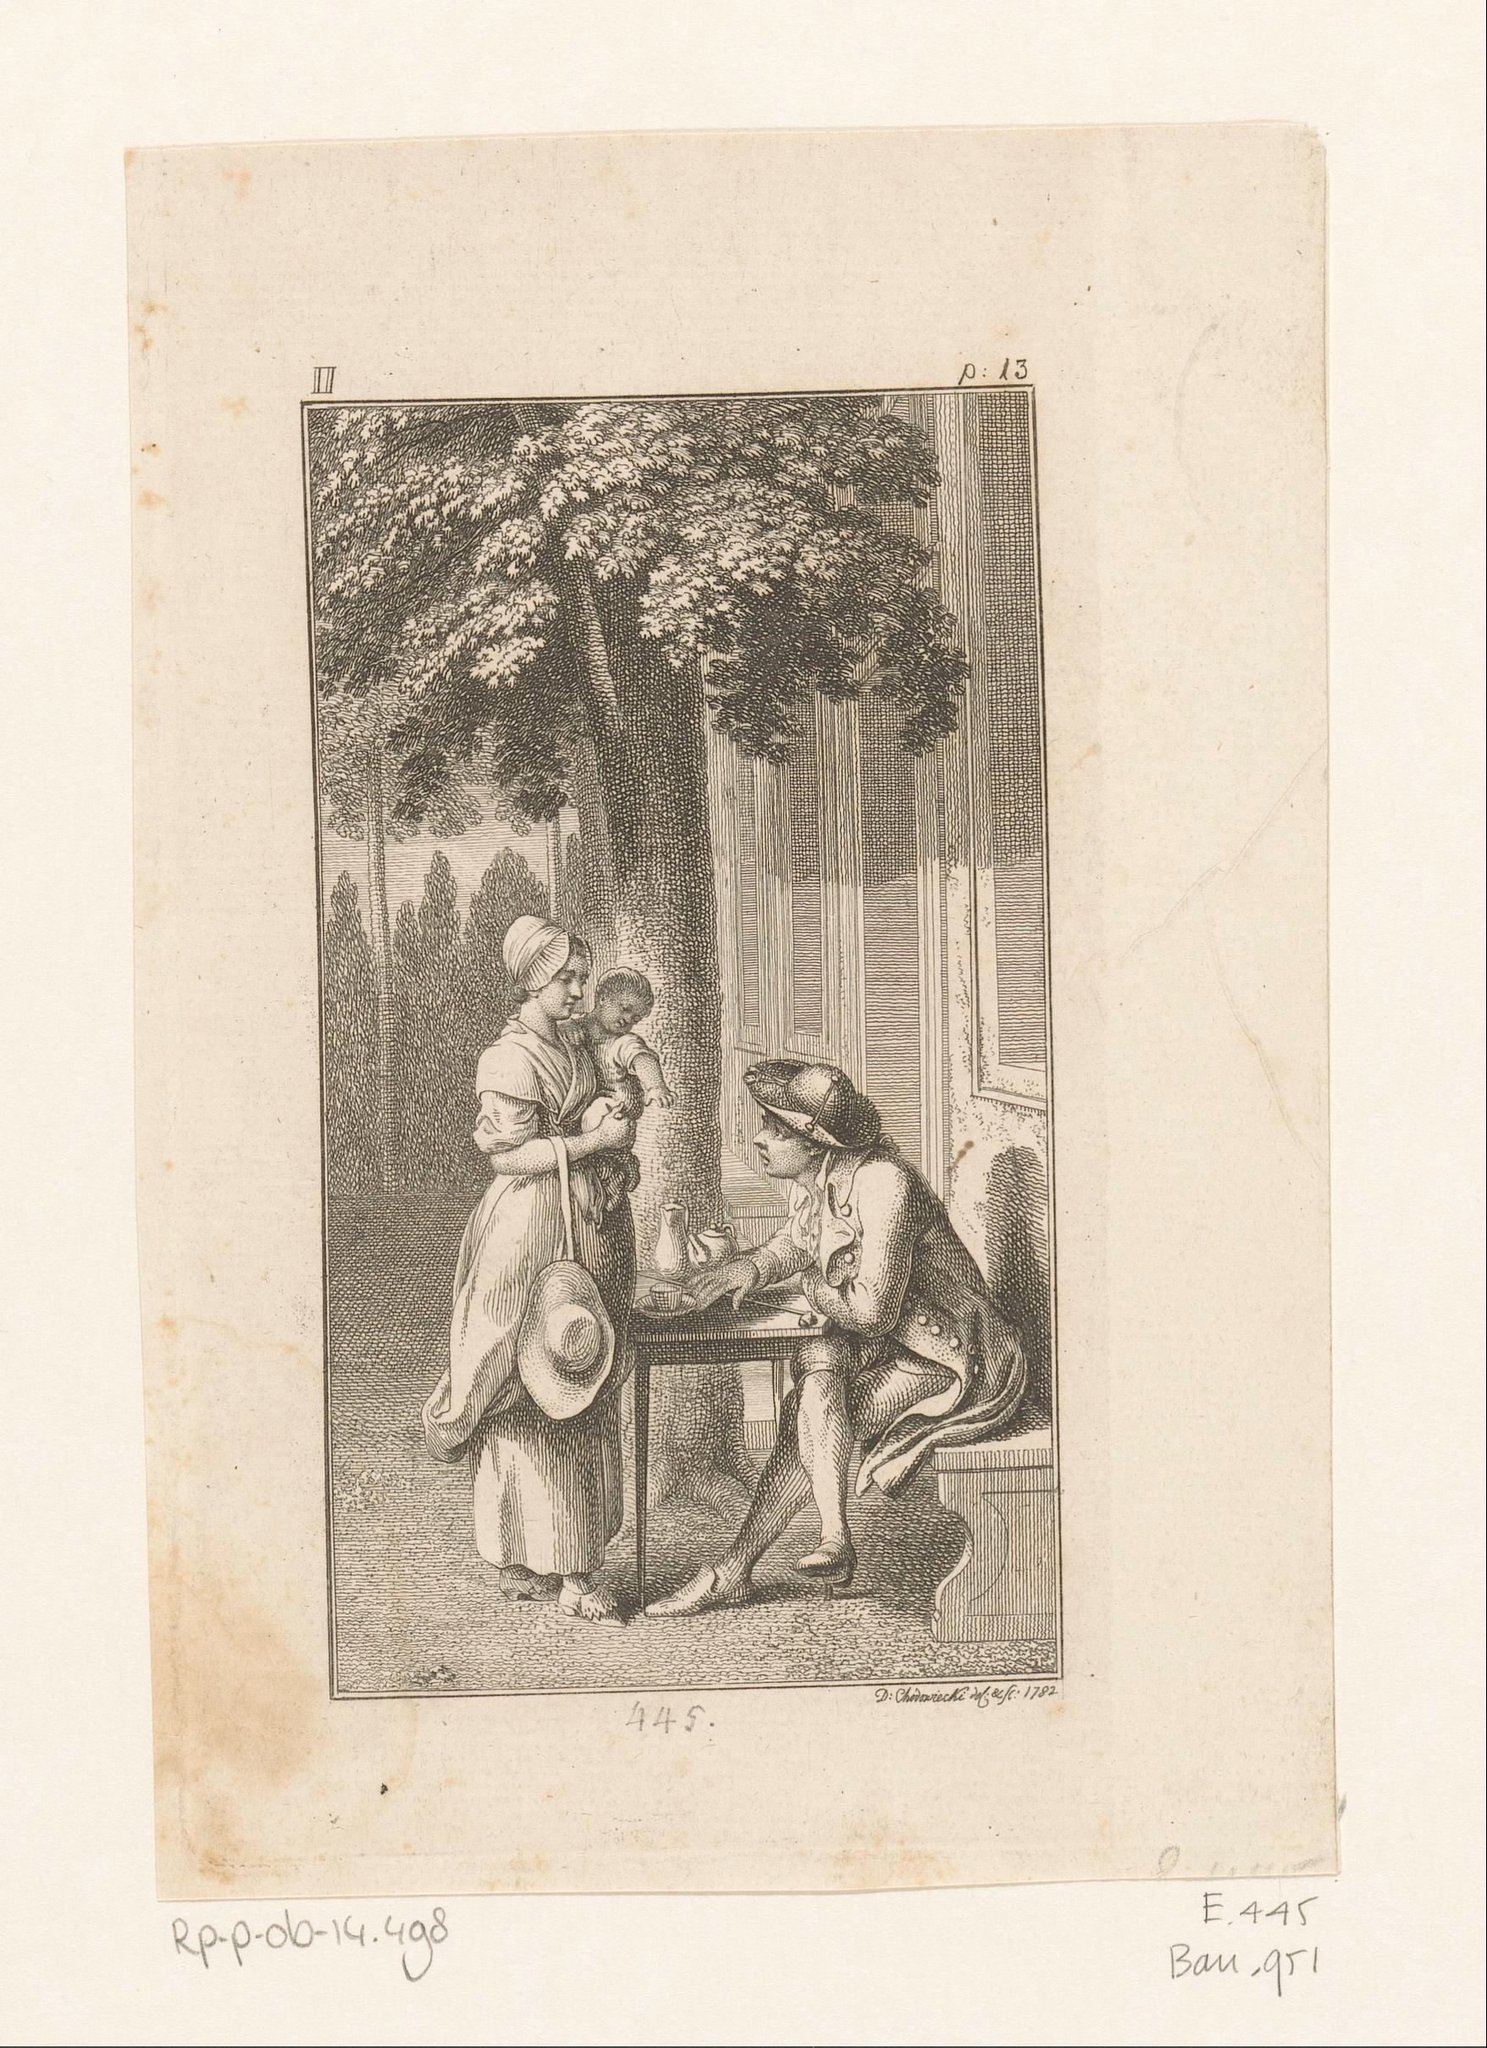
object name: print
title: Gertrude vraagt heer Arner om hulp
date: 1782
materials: paper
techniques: etching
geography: berlin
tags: politician, city-view, and landscape with man-made constructions, afternoon tea - cc - out of doors, mother and baby or young child, feudal lord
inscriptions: collector's mark: Lugt 2228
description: Prent gebruikt voor: Pestalozzi, Johann Heinrich. Léonard et Gertrude ou Les moeurs villageoises, telles qu'on les retrouve à la ville & à la cour. Berlijn: George Jacques Decker, 1783.